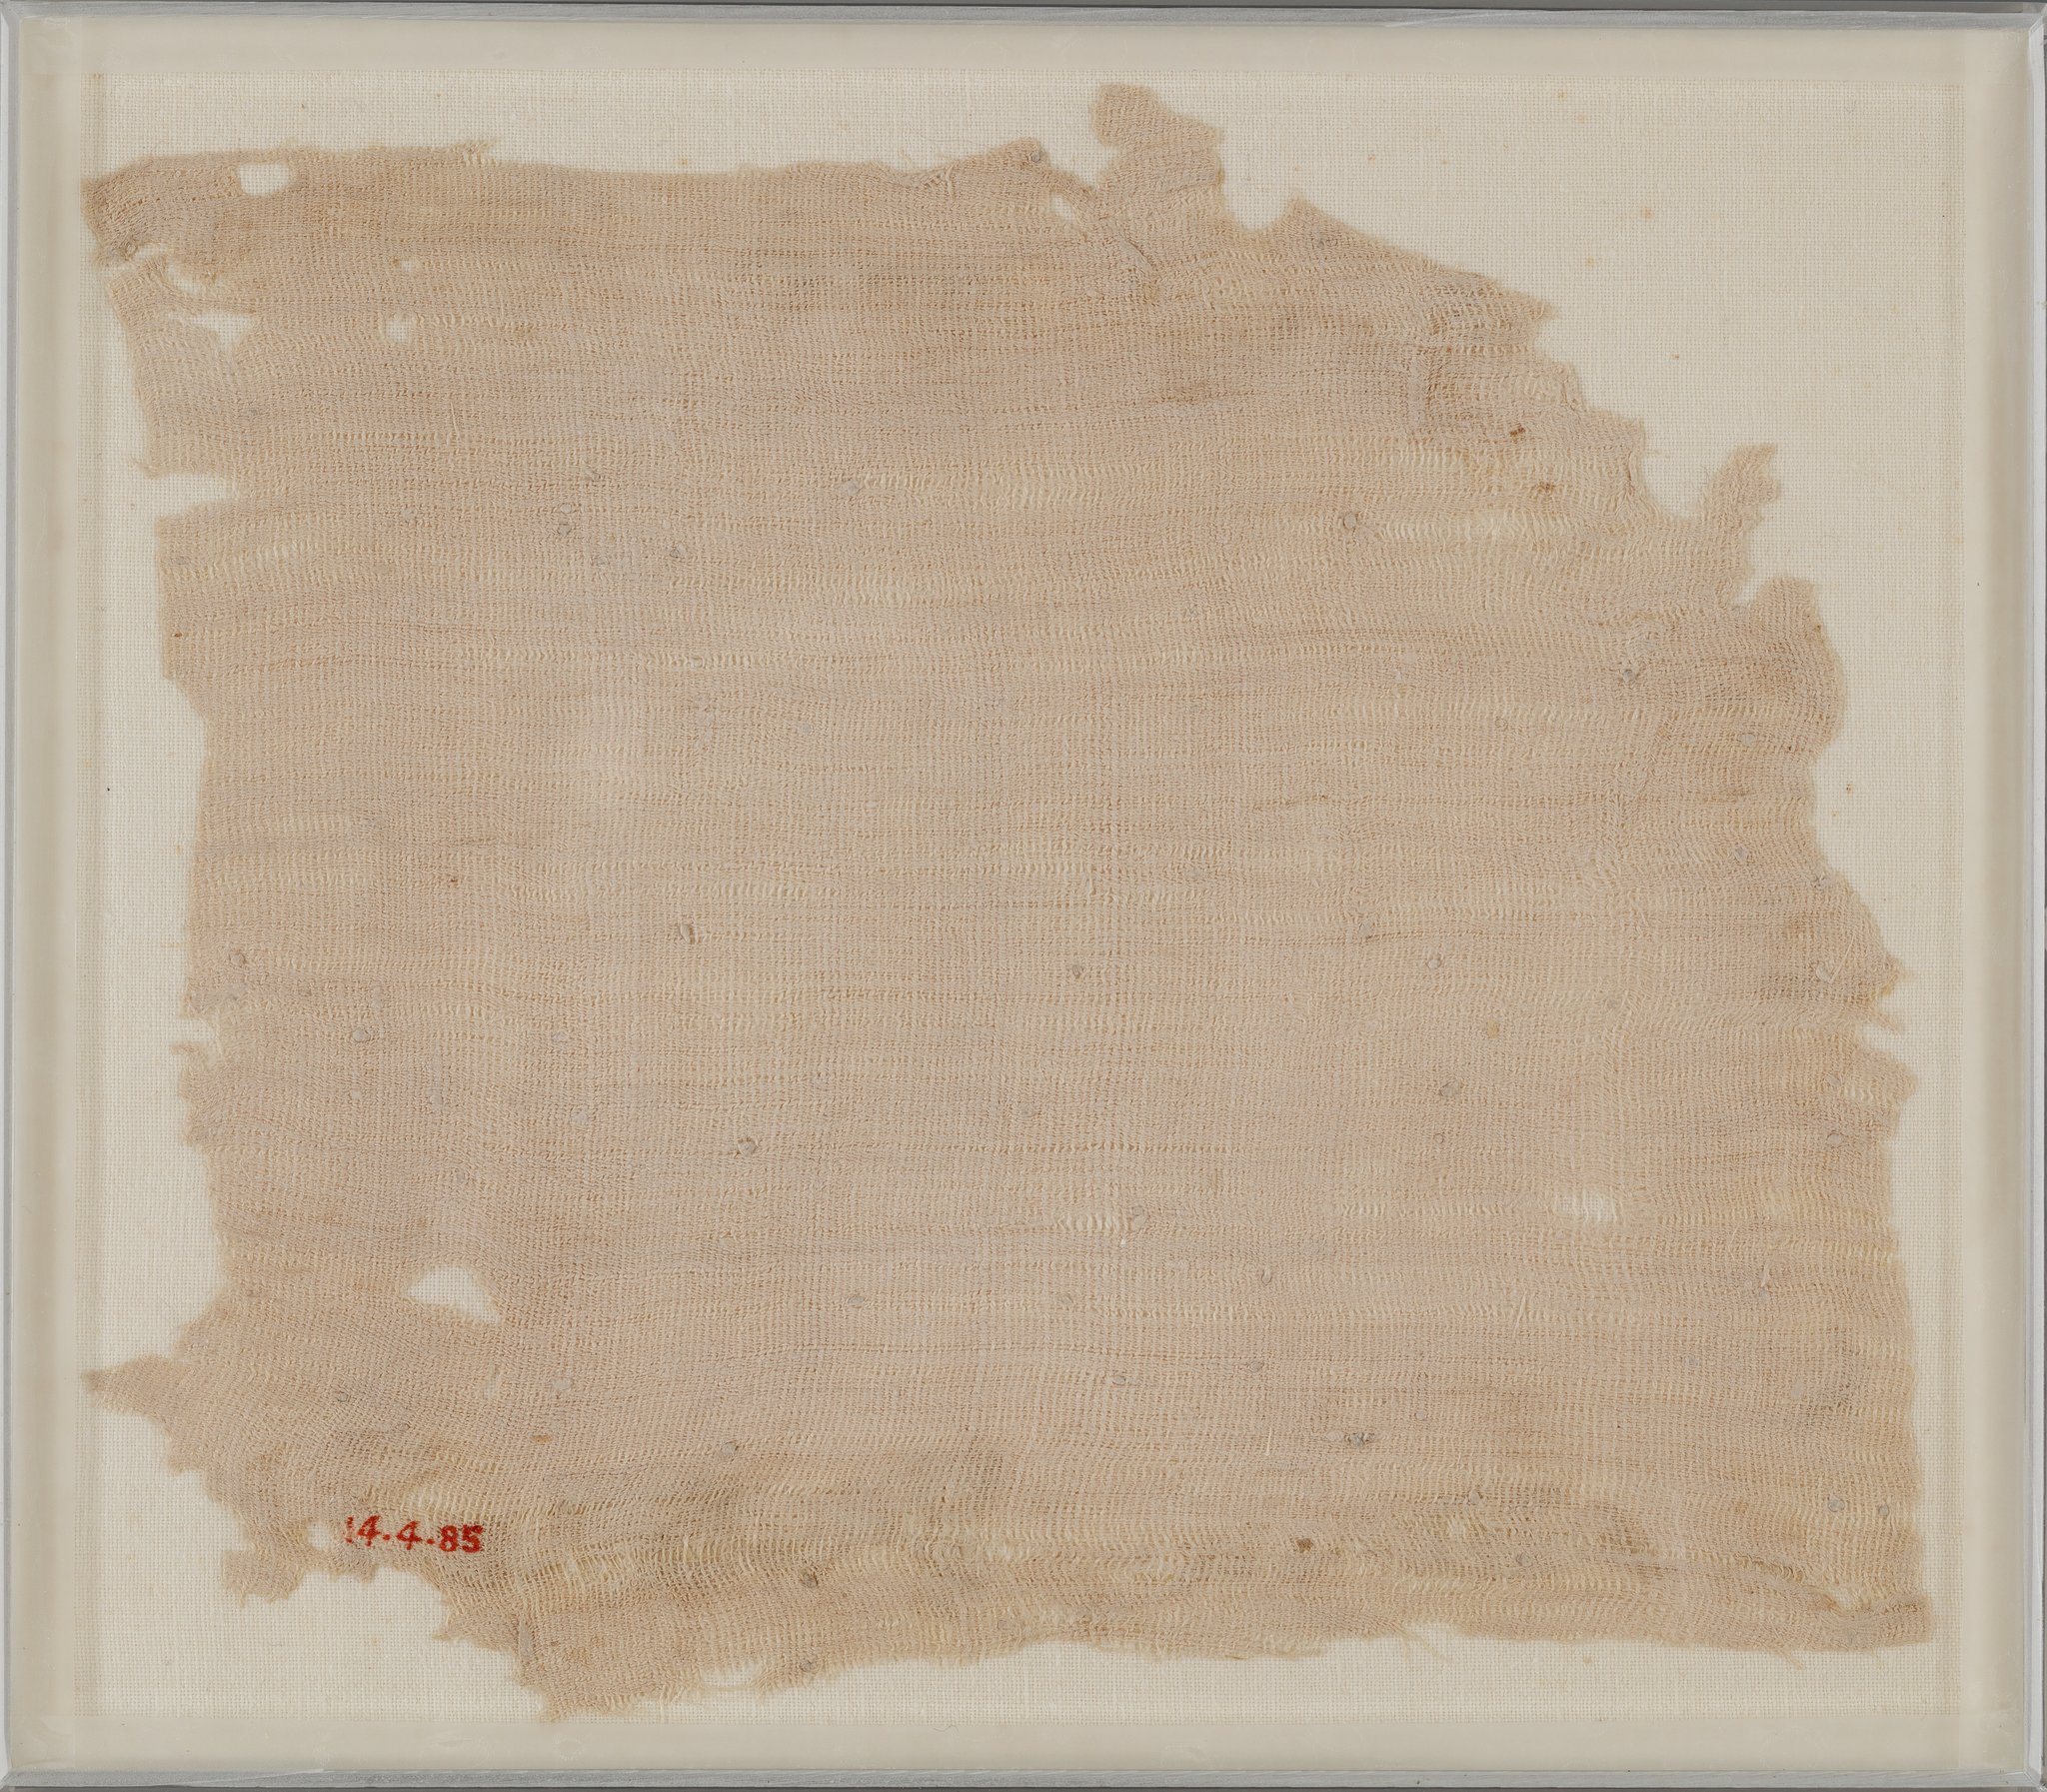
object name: linen fragment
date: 2880-2465 BCE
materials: linen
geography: egypt